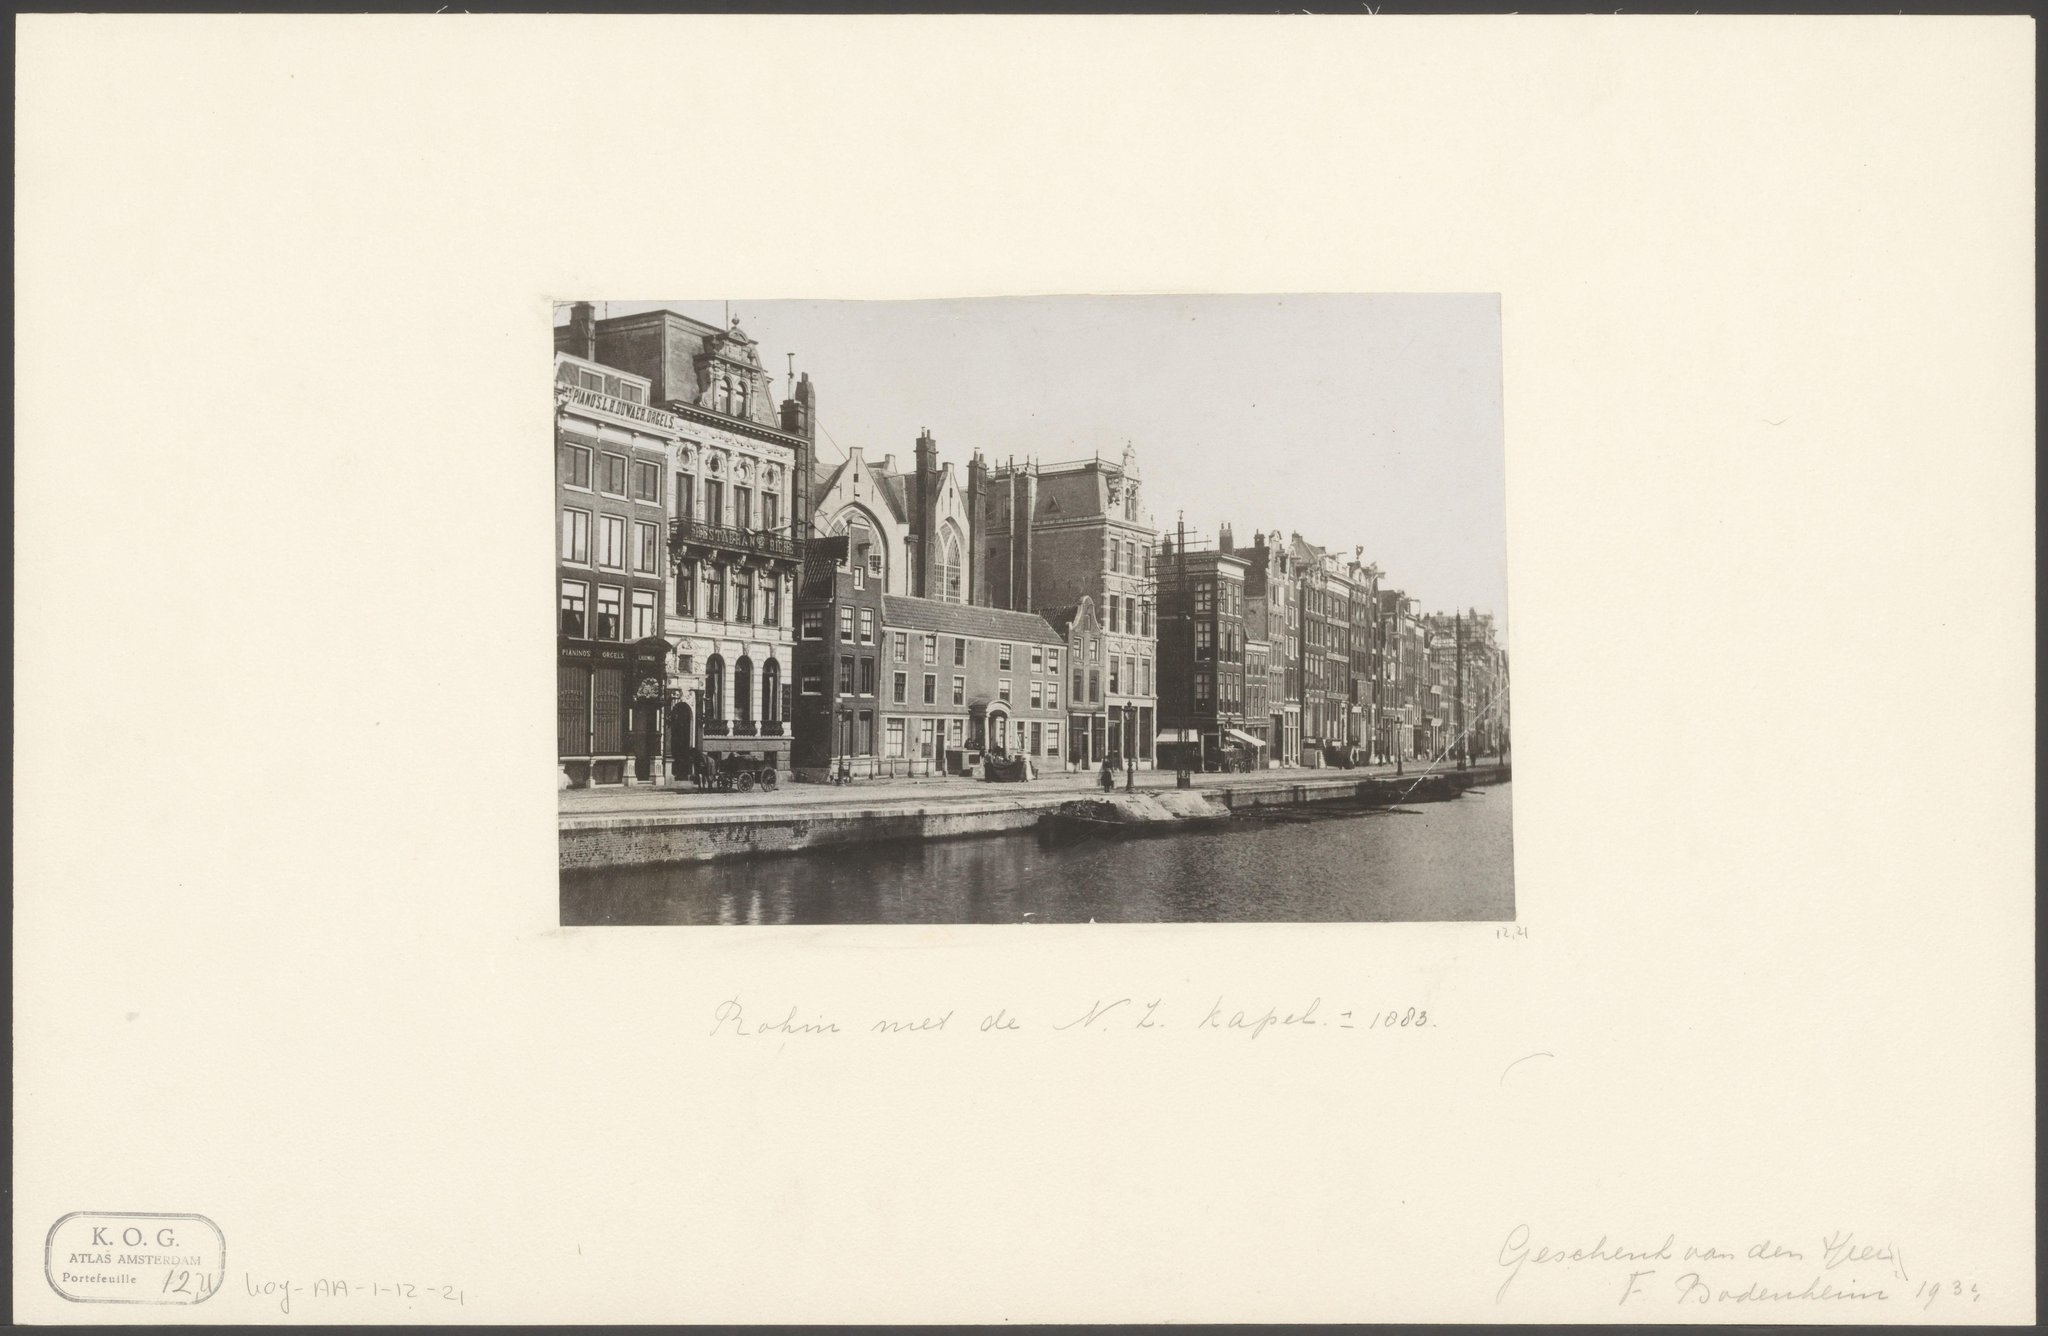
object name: photograph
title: Gezicht op het Rokin en de Nieuwezijds Kapel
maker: Anonymous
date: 1883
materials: paper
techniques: gelatin silver print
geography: amsterdam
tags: parts of church exterior and annexes: chapel - qq - small church, chapel, city-view in general; 'veduta', canal, the usual house or row of houses, street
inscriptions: inscription: ‘Rokin met de N.Z. kapel. +- 1883. / Geschenk van den Heer / F. Bodenheim 1934’, collector's mark: ‘12,21’ Lugt 1641b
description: Onderwerpsrubriek binnen de Atlas Amsterdam: Rokin, Rotterdammersloot, Rozengang, Rozengracht, Rozenstraat, Rusland, Rustenburgerstraat, Ruysdaelkade, Ruysdaelstraat, Ruyterkade (de), Ruyterweg (Admiraal de).